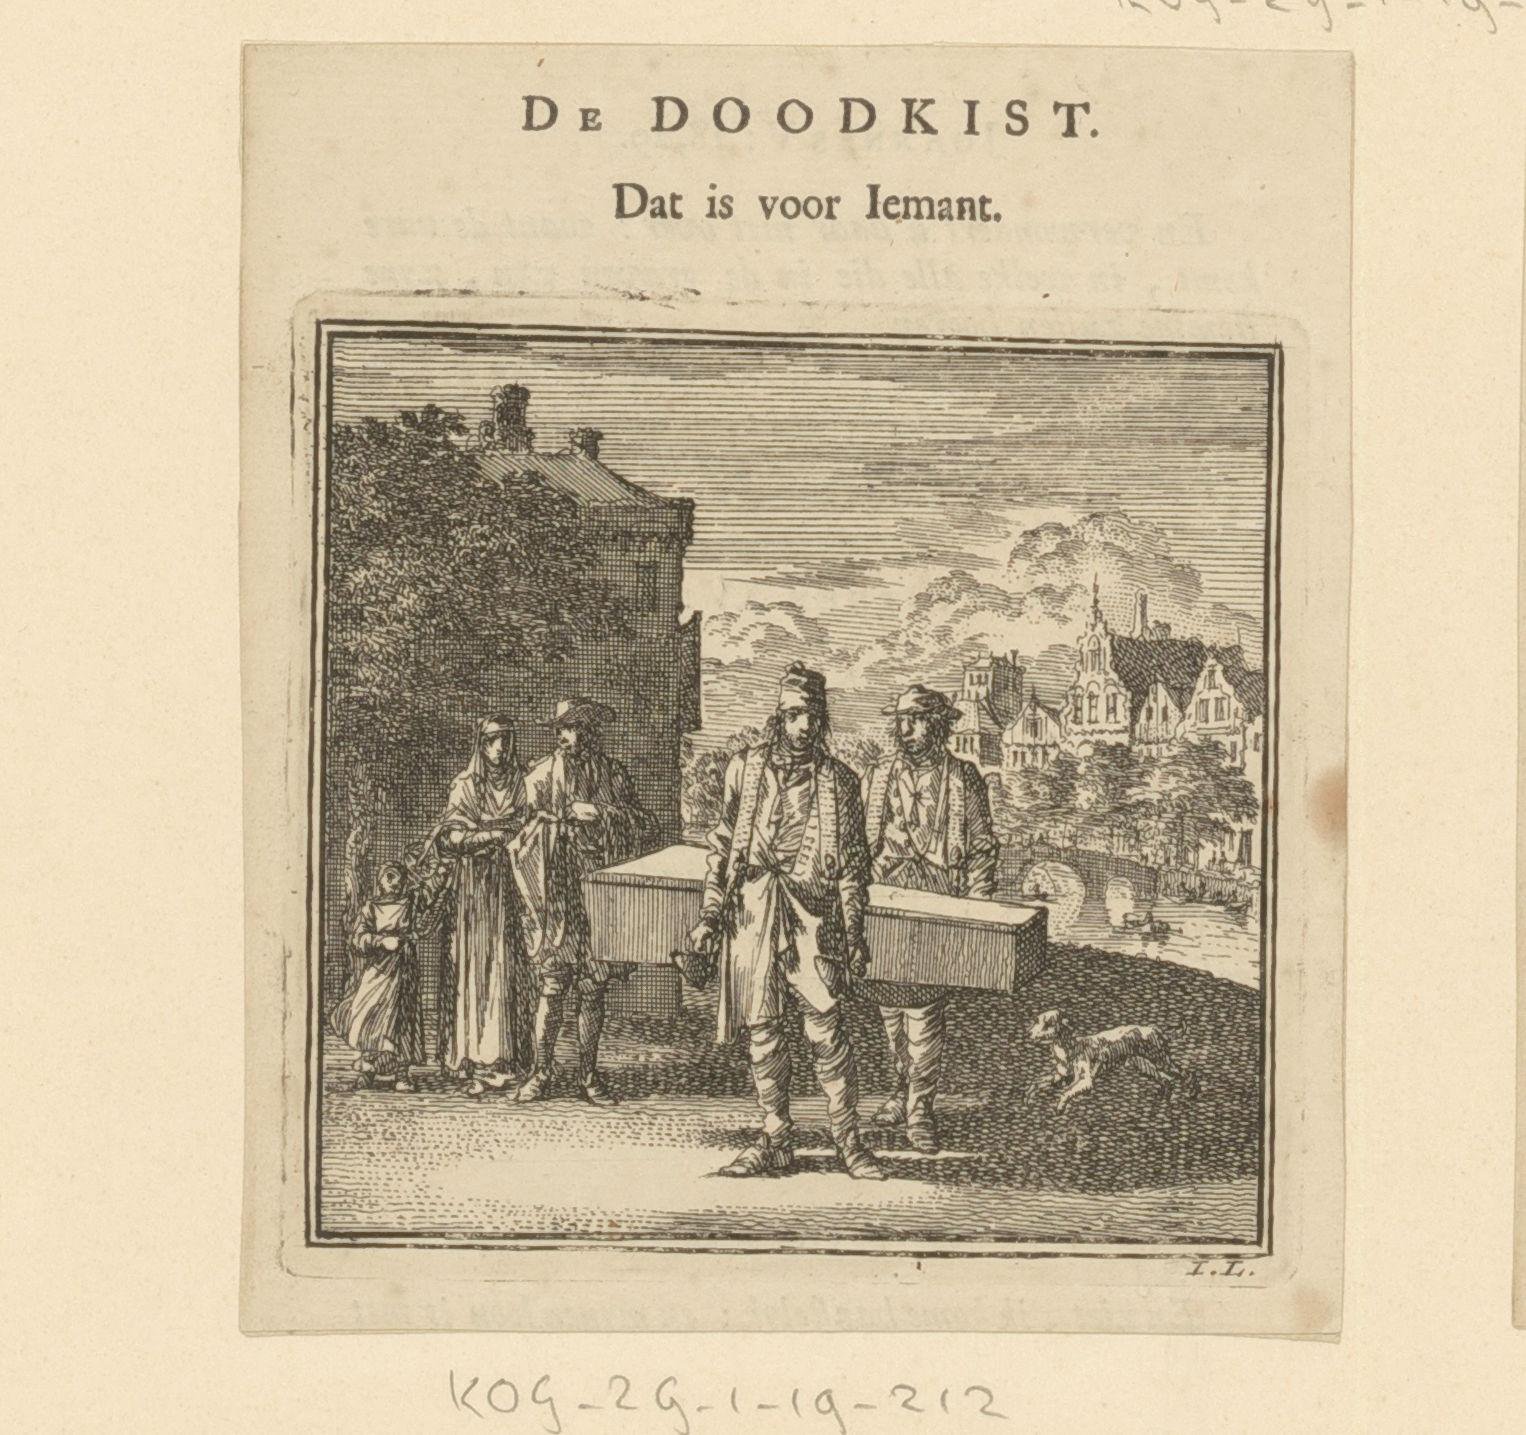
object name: book illustration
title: De Doodskist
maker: jan luyken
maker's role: draughtsman, print maker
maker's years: 1649-1712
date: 1711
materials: paper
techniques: etching, letterpress printing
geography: amsterdam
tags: coffin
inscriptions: collector's mark, collector's mark: Lugt 1641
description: Een doodskist wordt door twee mannen naar een sterfhuis gebracht. Met een spreuk boven de plaat. Onderwerpsrubrieken binnen de Atlas Zeden en Gewoonten: Des Menschen Begin, Midden en Einde. Begrafenissen, aansprekers, doodgravers, enz.